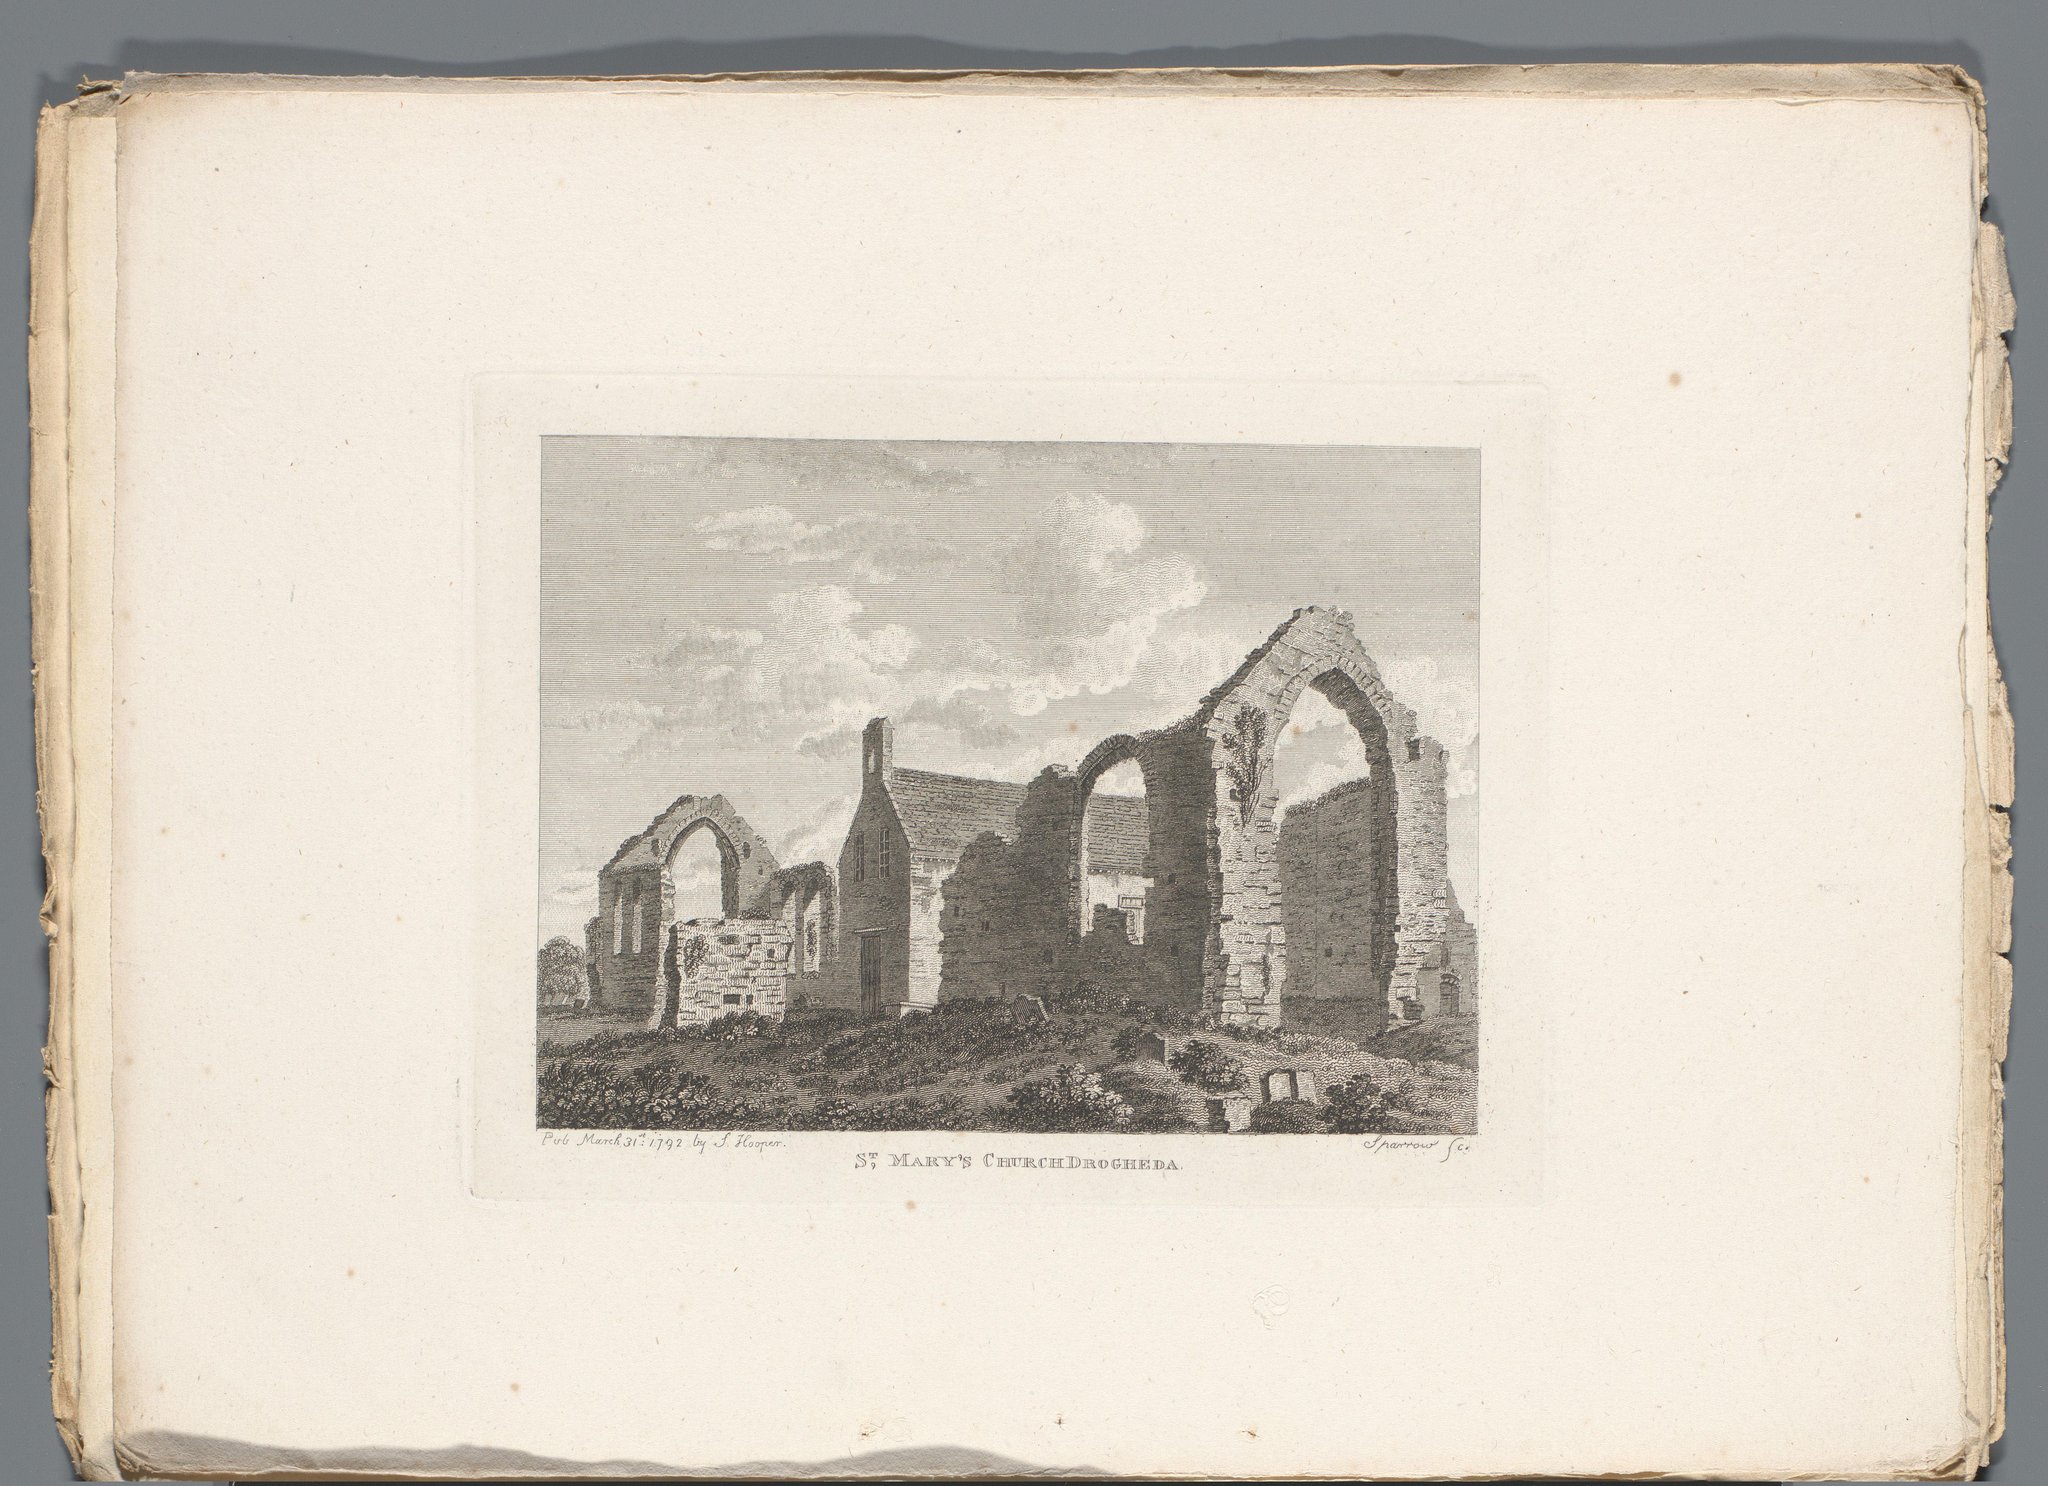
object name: print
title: St. Mary's Church Drogheda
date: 1792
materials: paper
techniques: etching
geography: london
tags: city-view, and landscape with man-made constructions, landscape with ruins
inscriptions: date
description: Prent verschenen in: Grose, Francis. The antiquities of Ireland. Londen: S. Hooper, 1795, dl. 2.